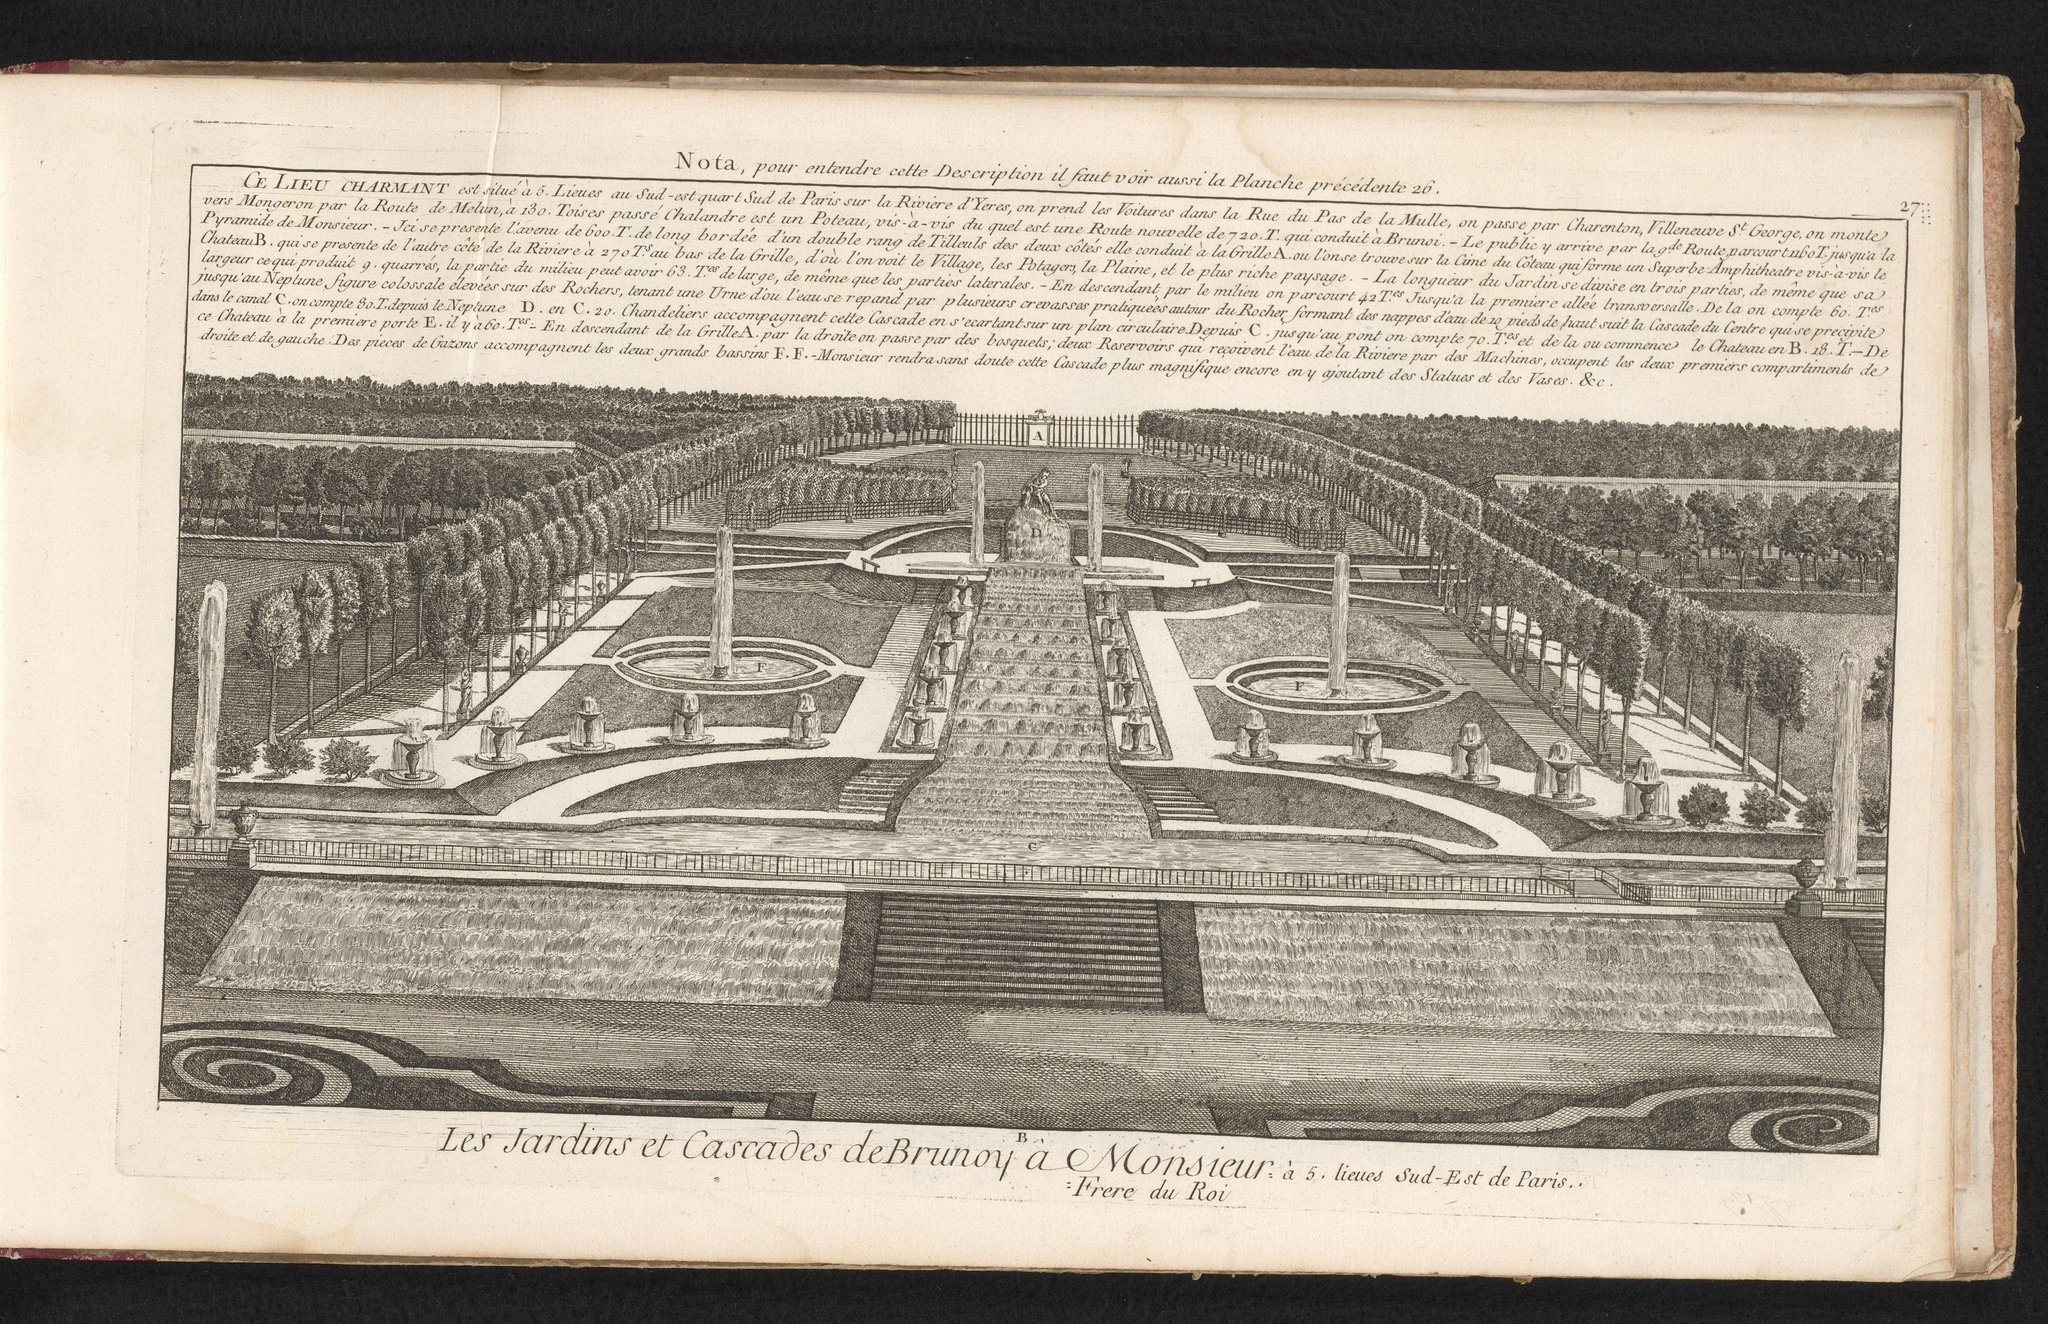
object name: print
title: Landschapstuinen in Chinees-Engelse stijl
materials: paper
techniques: engraving, etching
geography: paris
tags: plan, map of garden, lay-out of garden, garden cascade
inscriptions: collector's mark: Lugt 2228, collector's mark: Lugt 2760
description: De serie 'Jardins anglo-chinois à la mode' verscheen in totaal in 21 zogeheten 'cahiers' (afleveringen). De huidige prent komt uit het achtste 'cahier'. Het Rijksmuseum Amsterdam bezit drie banden met daarin in totaal zes 'cahiers' van deze reeks. In de documentatie wordt verwezen naar een in de bibliotheek van het Rijksmuseum Amsterdam aanwezige facsimile van het complete werk.